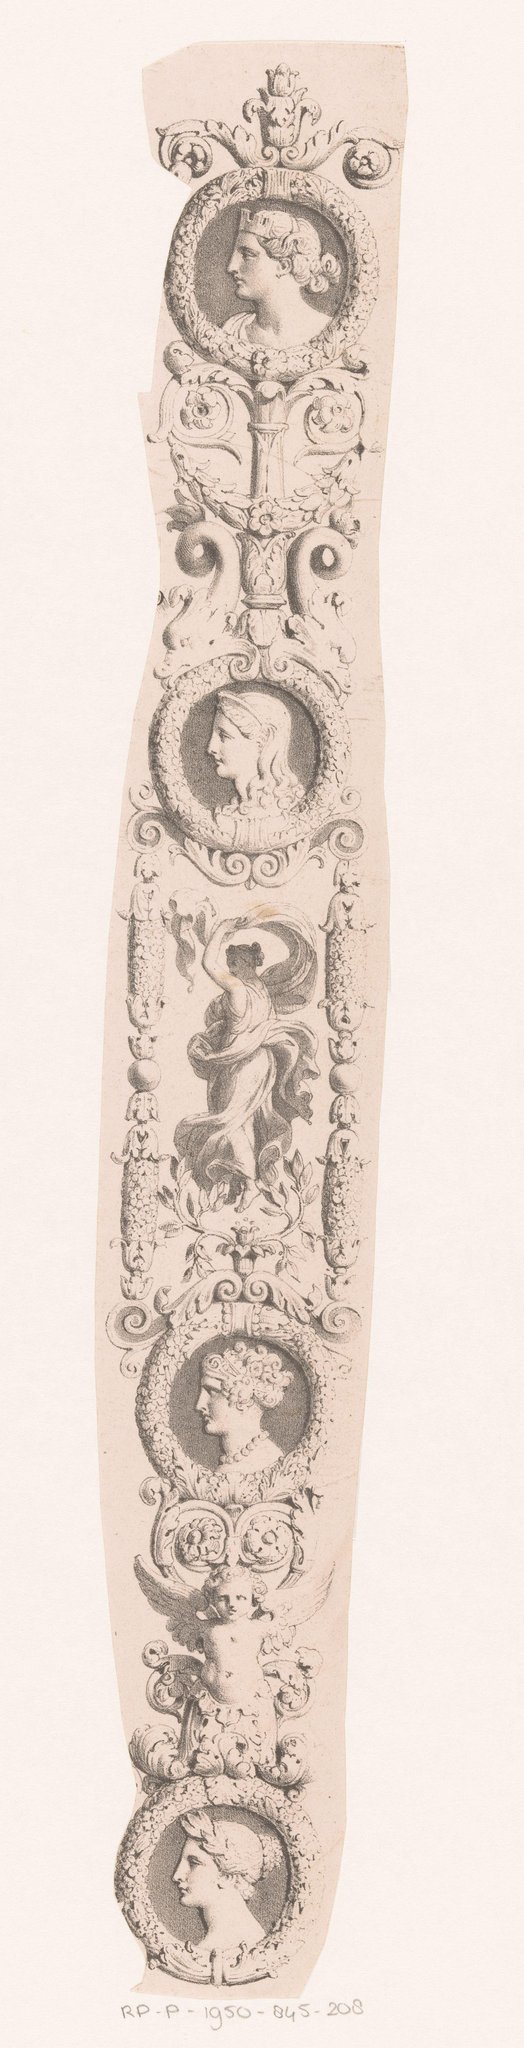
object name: print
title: Ornament met medaillons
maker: Anonymous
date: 1700-1800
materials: paper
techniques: printmaking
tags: ornaments ~ art, ornament ~ medallion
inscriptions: collector's mark: Lugt 2228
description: Prent afkomstig uit een plakalbum met titelprenten, ornamenten etc. op blauw papier in 1983 uit elkaar gehaald. Volgens een notitie op verso zat de prent op p. 208 van dit album.